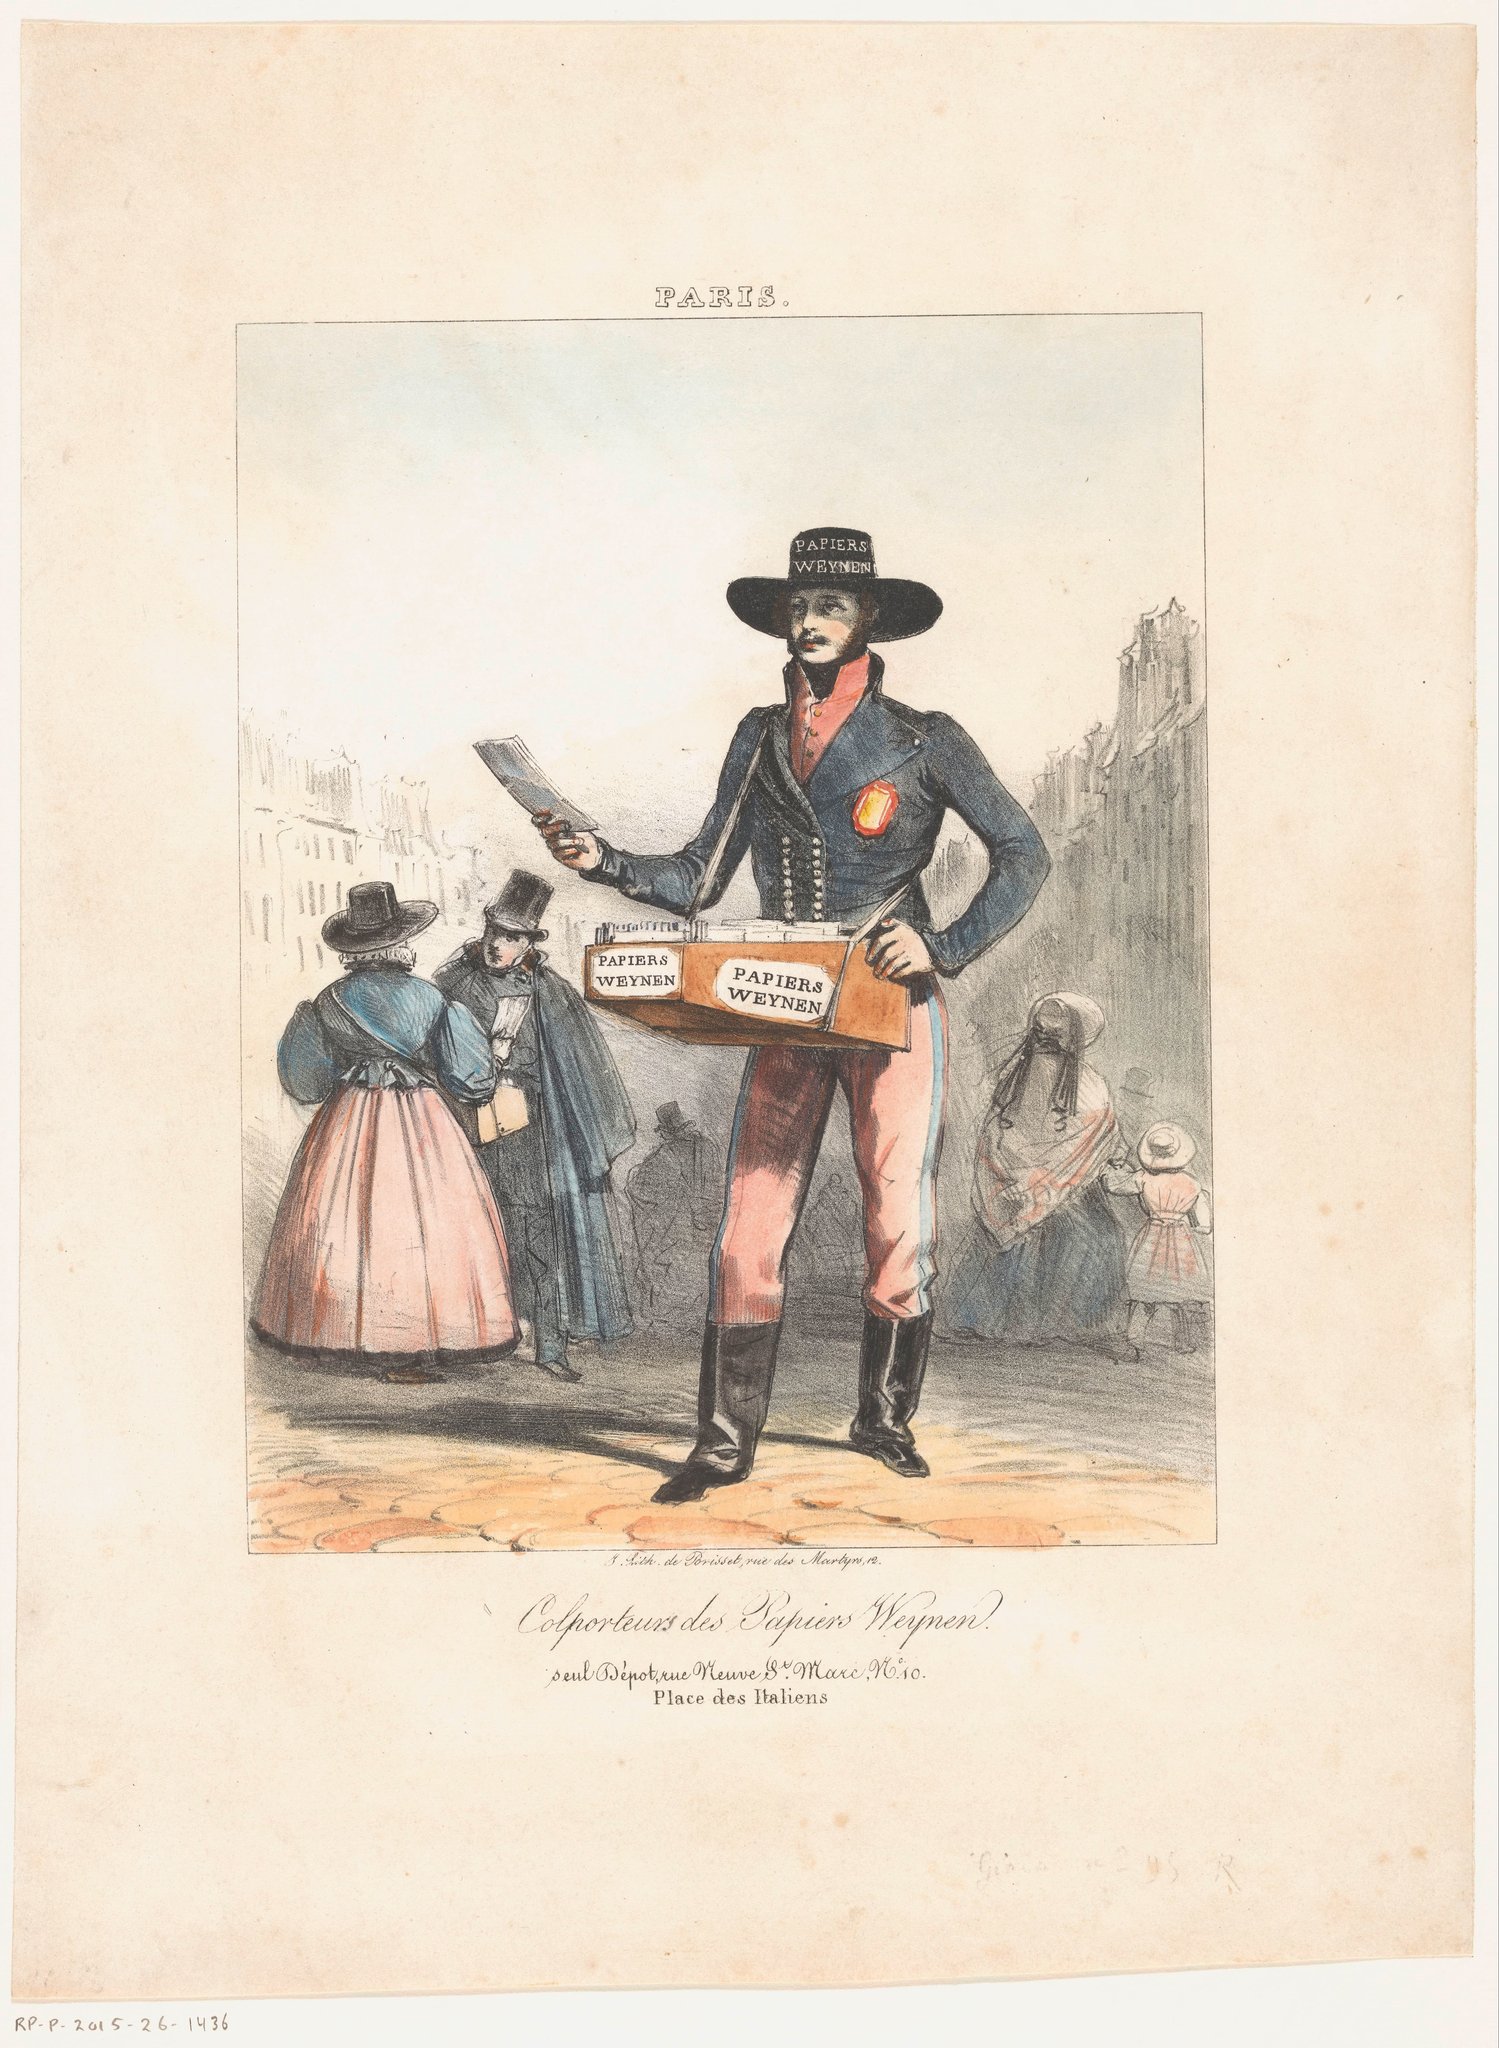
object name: print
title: Straatverkoper van Weynen papier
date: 1833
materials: paper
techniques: hand coloring, lithograph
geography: paris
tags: street-trader, paper (writing material), paris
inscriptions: collector's mark: Lugt 2228, collector's mark: Lugt 4779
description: Straatgezicht met een man met een hoed en een doos voor zijn buik. Op zijn hoed en op de doos staat 'Papiers Weynen'. In de achtergrond verkoopt zijn vrouwelijke collega papier aan een man.